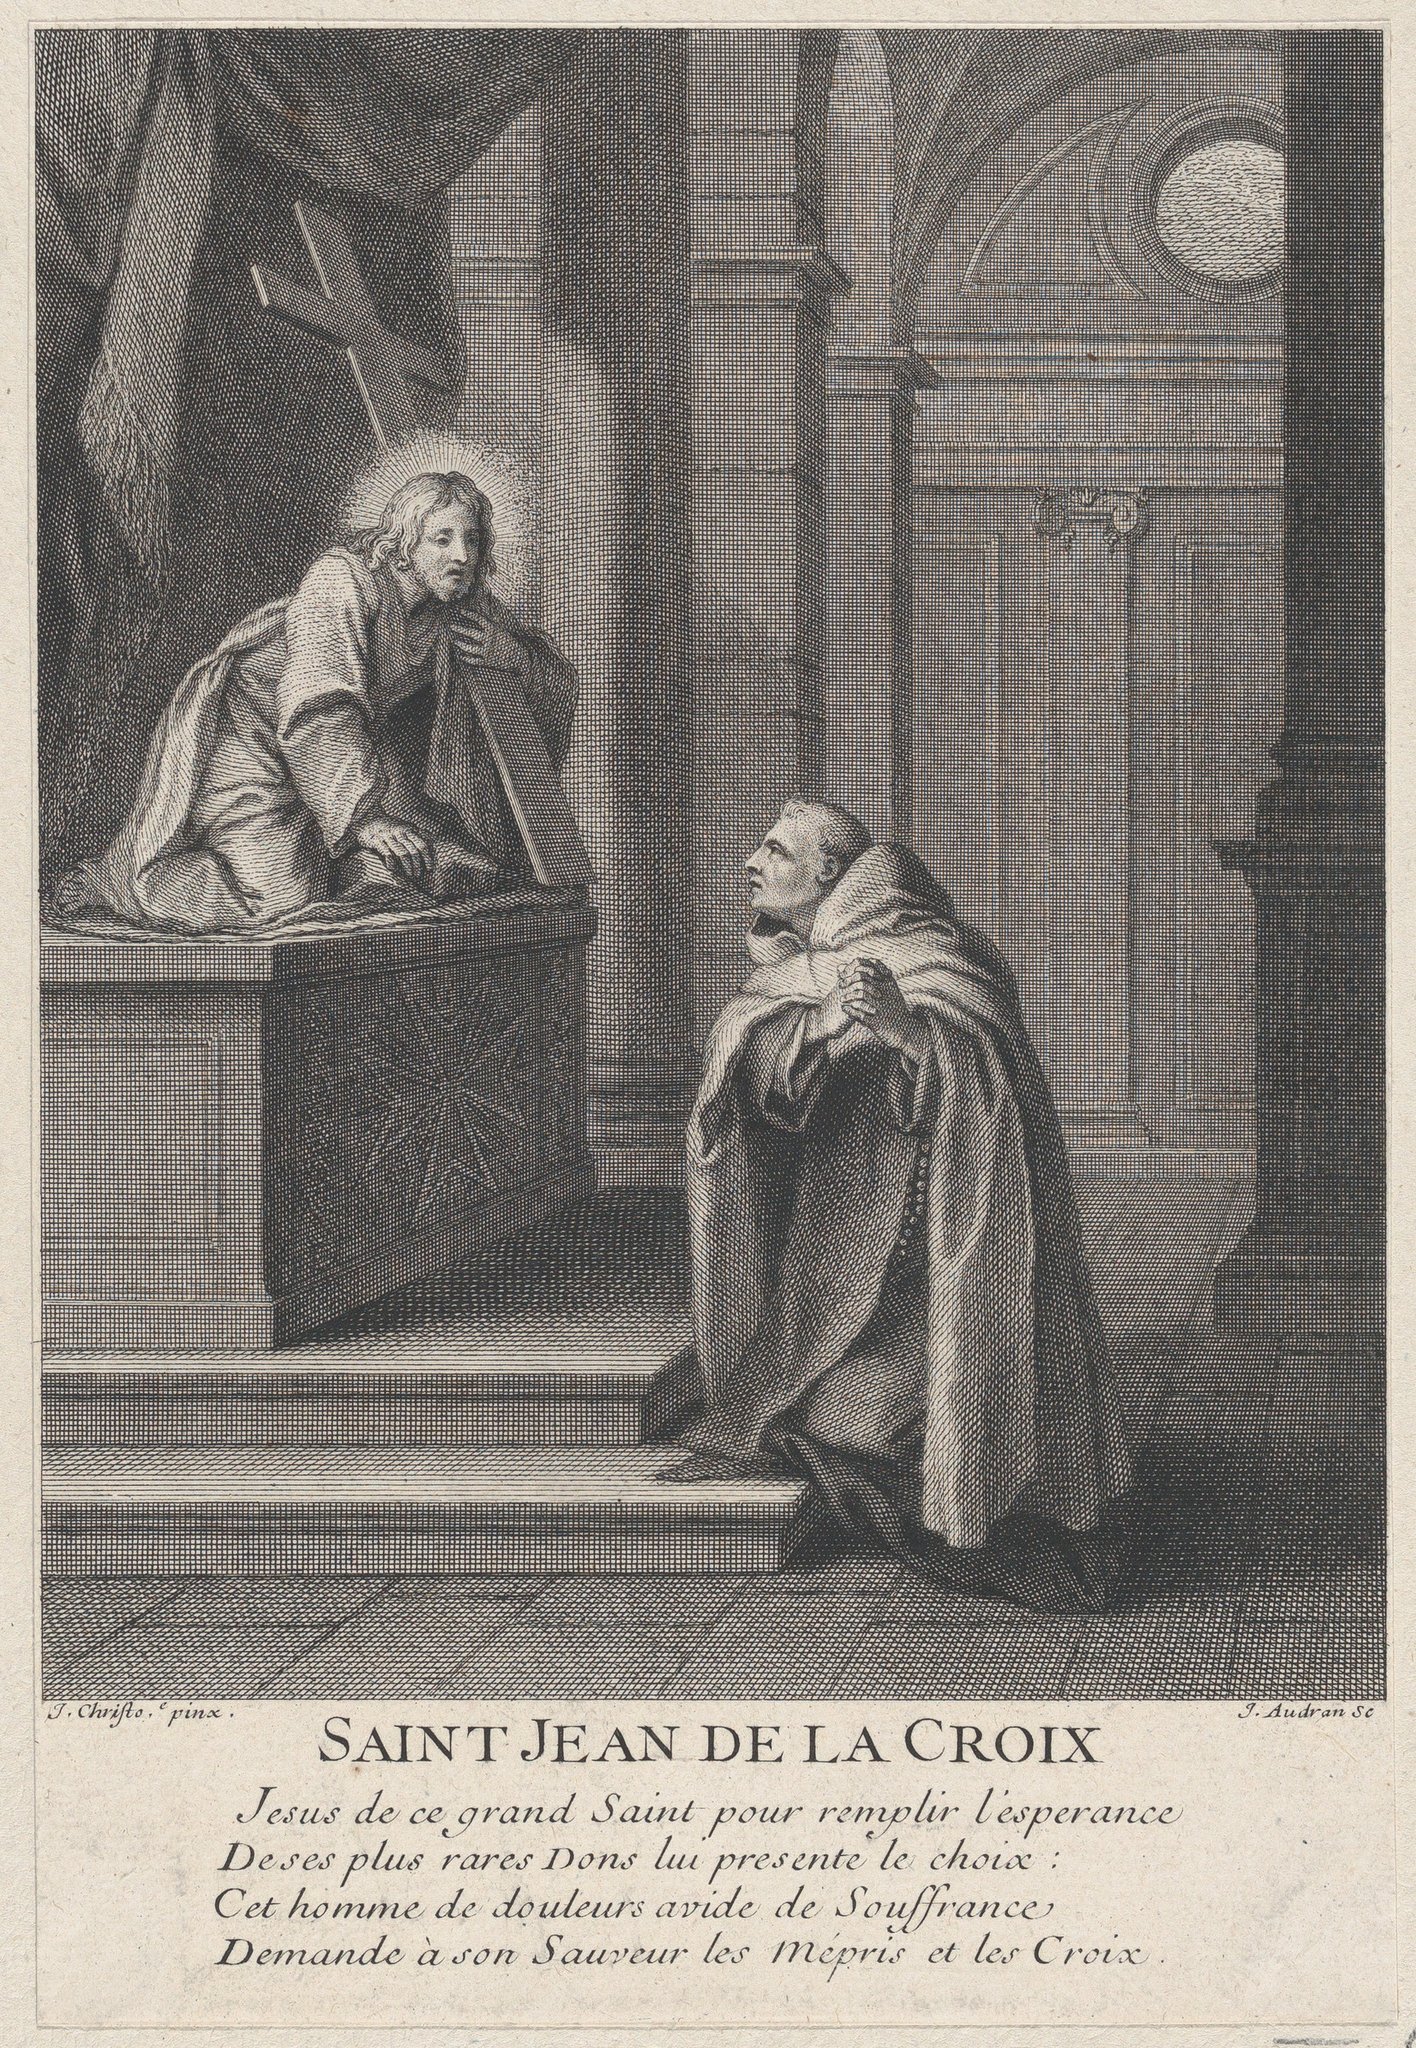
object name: print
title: St John of the Cross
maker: jean audran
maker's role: artist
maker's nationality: french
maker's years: 1667-1756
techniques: engraving, etching